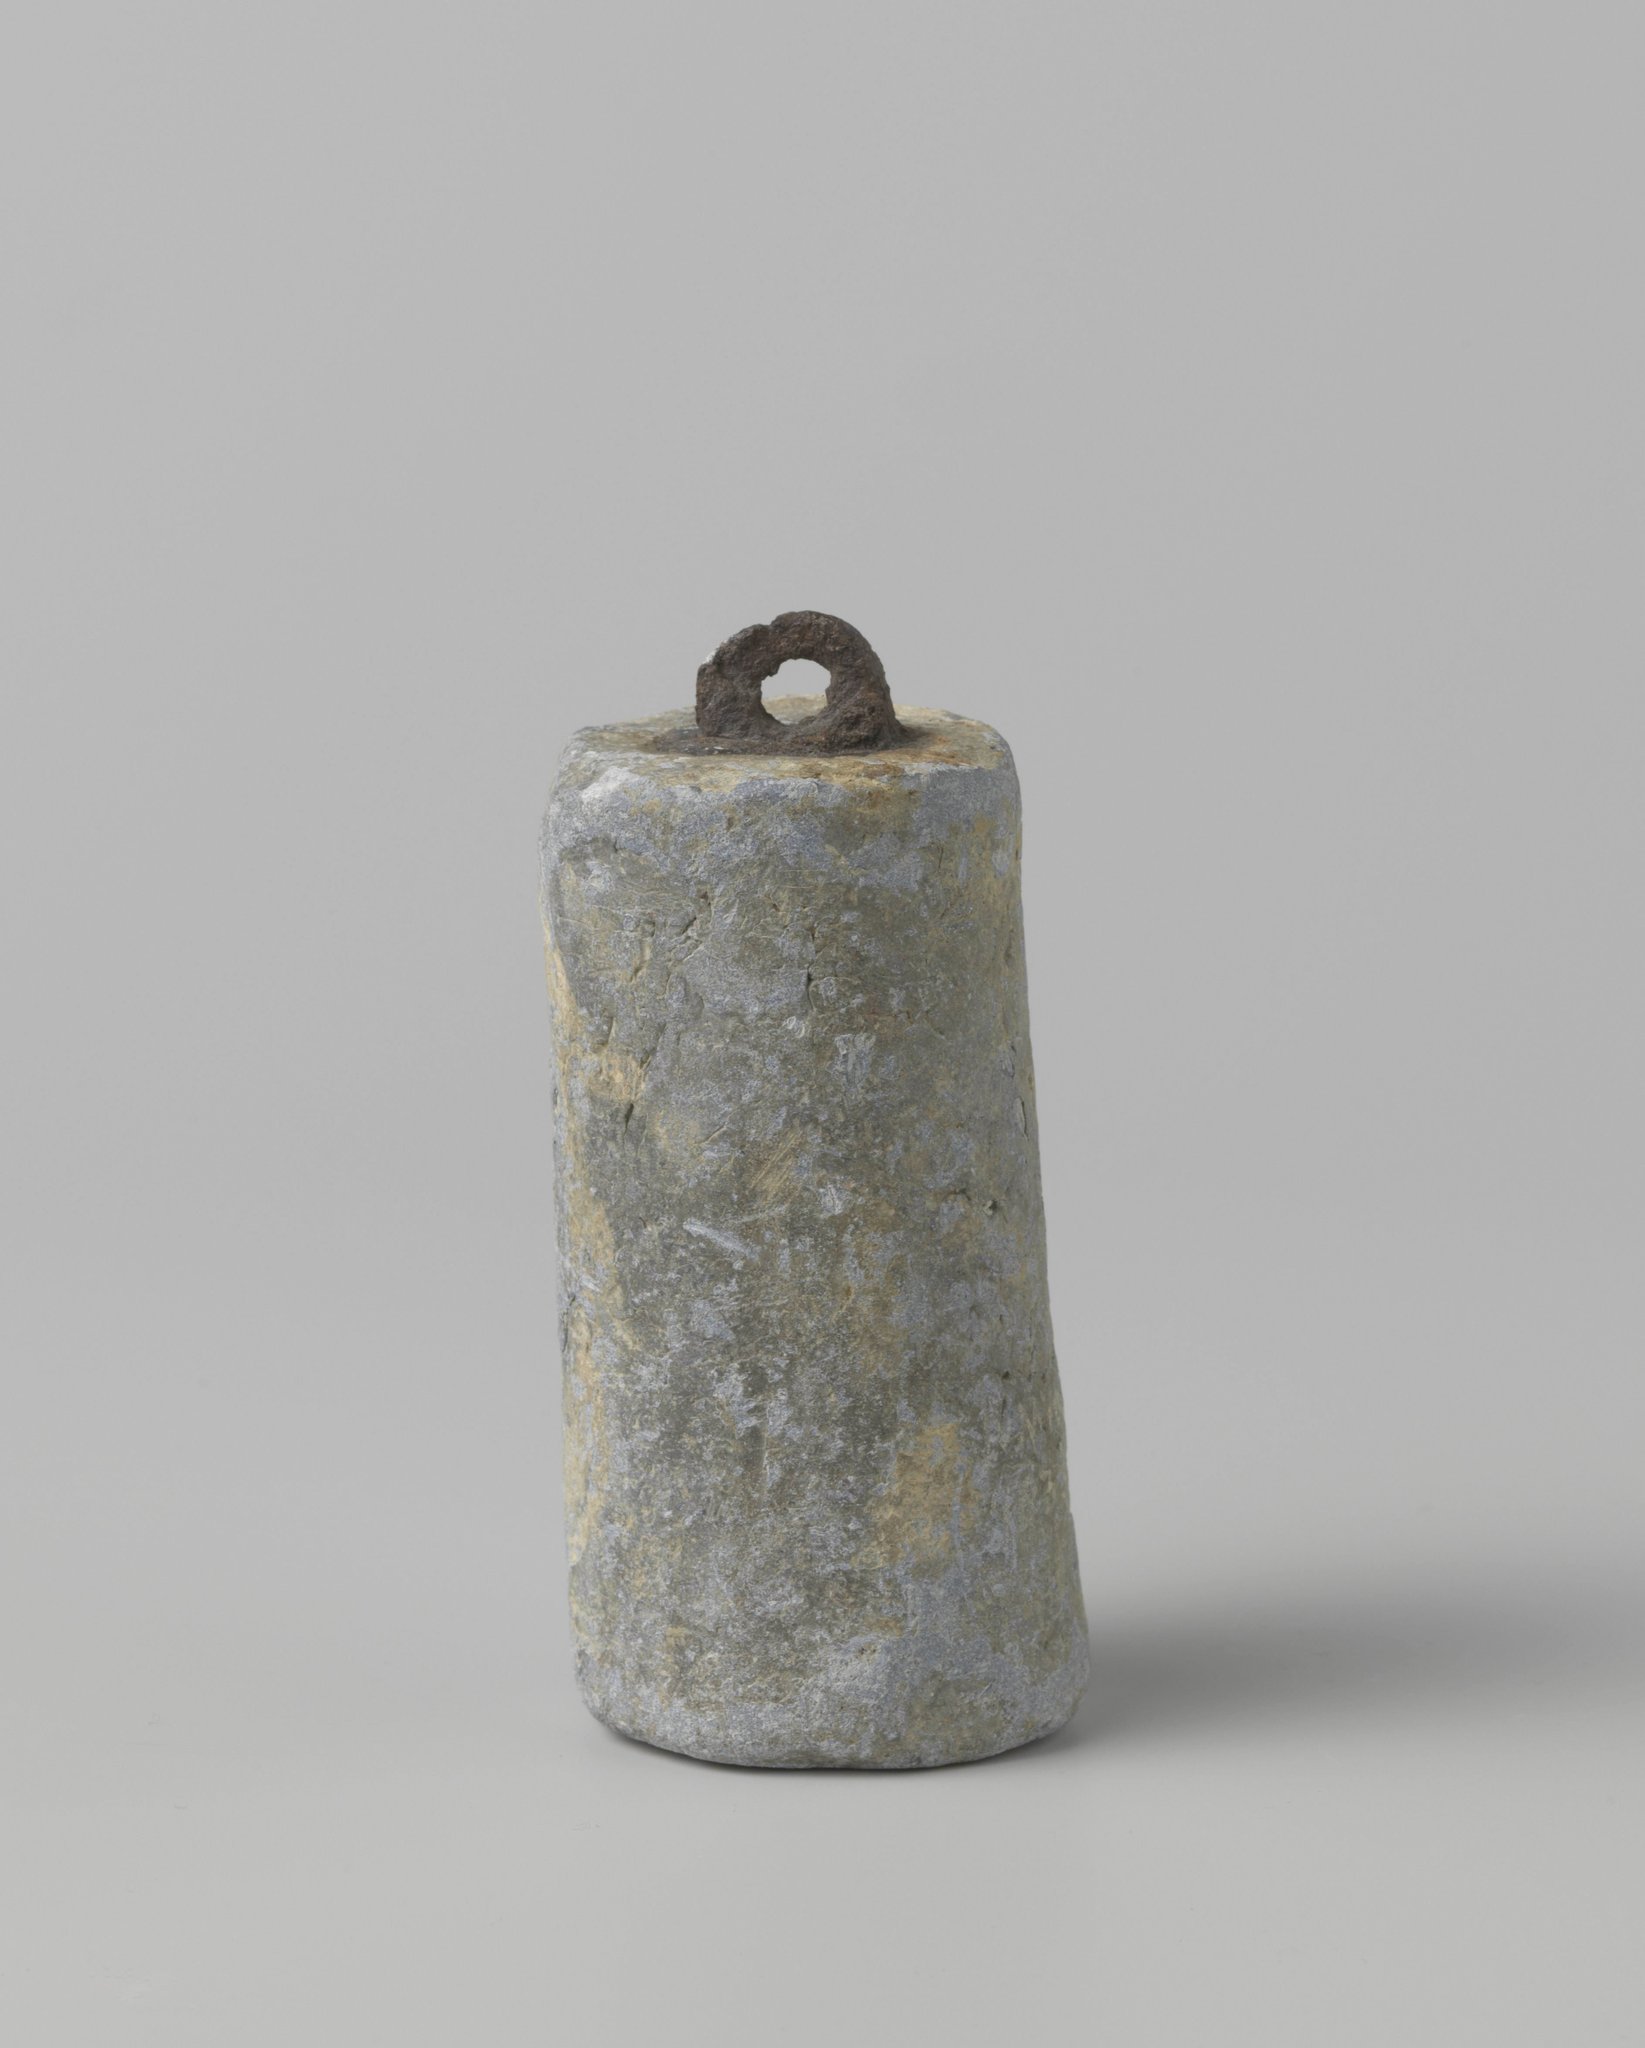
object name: clockwork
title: Clock and gunpowder horn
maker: Anonymous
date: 1590-1596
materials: iron, lead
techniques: casting, forging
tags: willem barendsz., amsterdam, jacob van heemskerck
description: This clock was originally intended as merchandise for sale or as a gift. It was hung up in the ‘Save House’ as the only means of providing a sense of time during the long, polar nights. On 3 December 1596, it froze. Barentsz and Van Heemskerck shoved a parting letter into the gunpowder horn when they left. Three centuries later, the horn was rediscovered with the letter still inside. The letter cannot be exhibited due to its fragility.